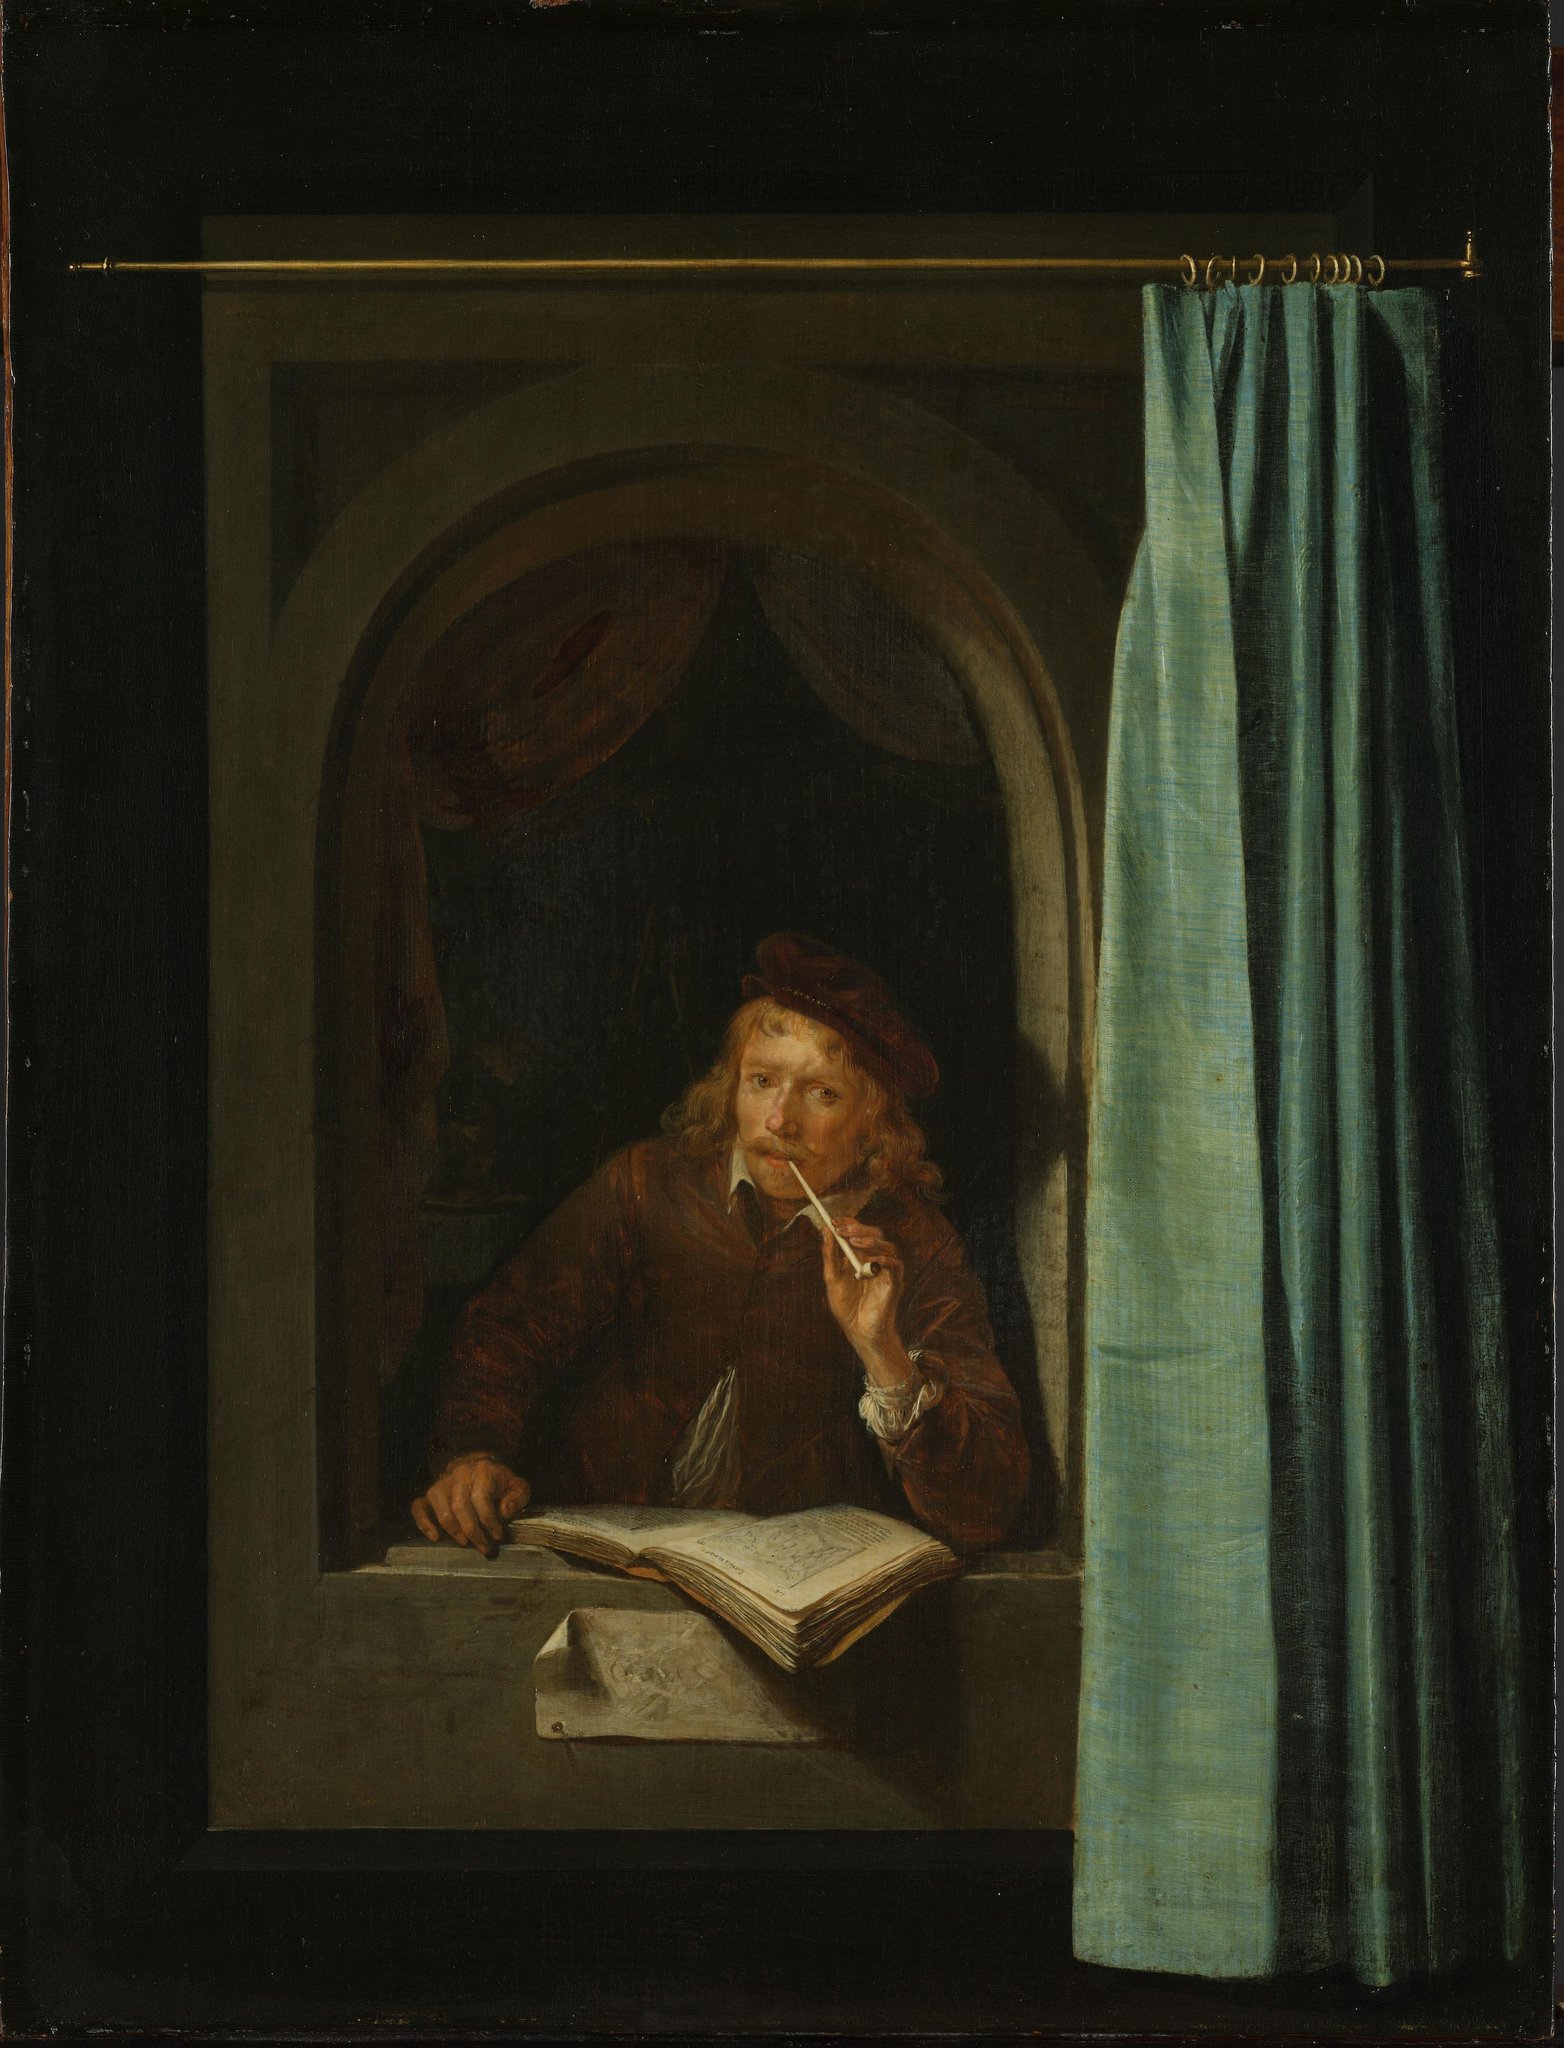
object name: painting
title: Man Smoking a Pipe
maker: gerard dou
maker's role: draughtsman, painter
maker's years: 1613-1675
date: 1650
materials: oil, panel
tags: leiden, draughtsman, gerard dou, pipe ~ tobacco, book - mm - book open, portrait, self-portrait of painter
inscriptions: signature: ‘GDou’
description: A young man leans on a window ledge, smoking a pipe and looking out at us. Dou was a master of illusionism. The open book on the sill seems to protrude from the window into our space, and the green curtain hanging from the copper rod is so realistically painted that we are tempted to draw it farther back. However, the painting’s small size gives away the deception.